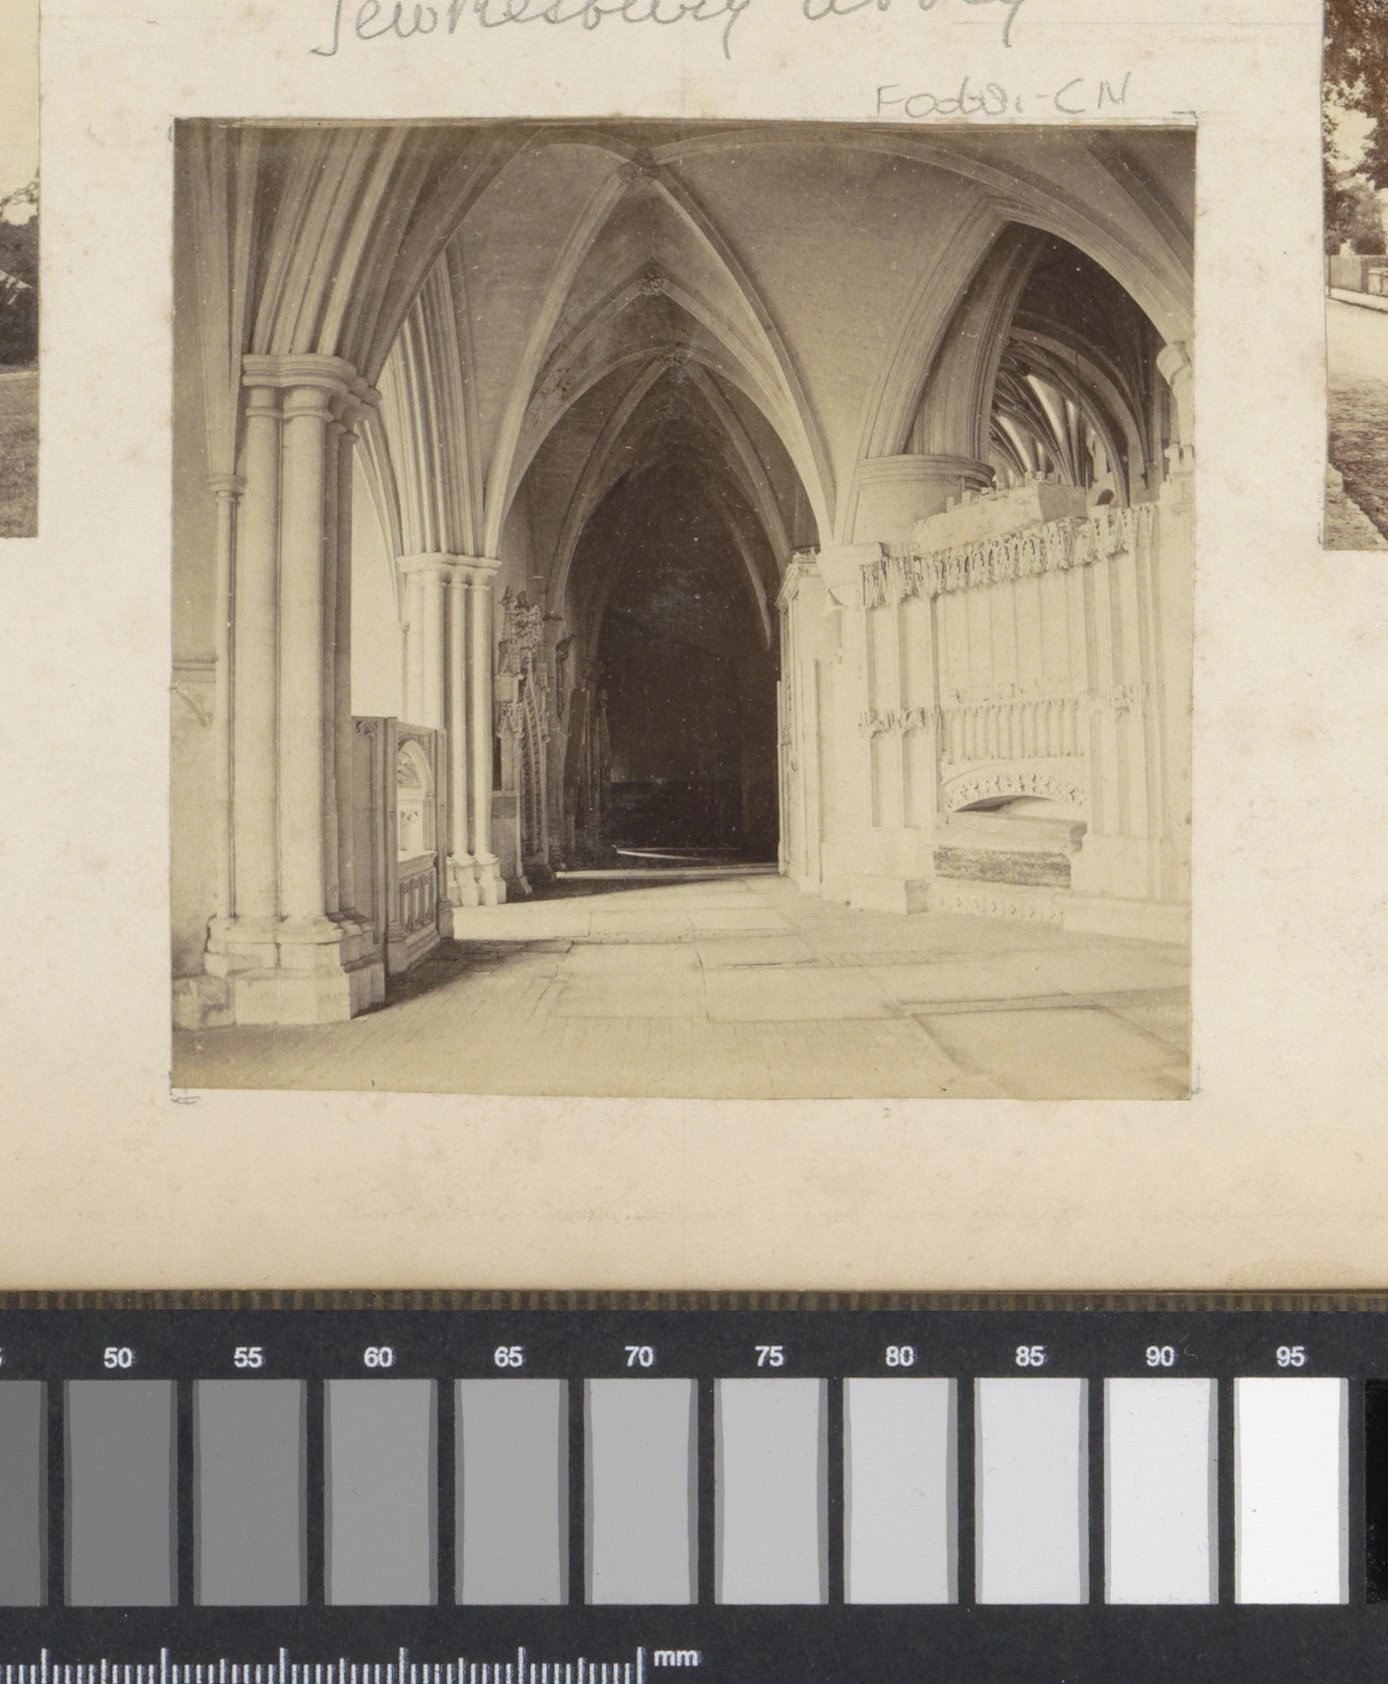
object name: photograph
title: Gewelven en gang van een kerk in Engeland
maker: Anonymous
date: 1850-1870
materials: paper, photographic support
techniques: albumen print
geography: england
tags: parts of church interior: vault, england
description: Onderdeel van Album met foto's van bezienswaardigheden en landschappen in Engeland en van kunst.